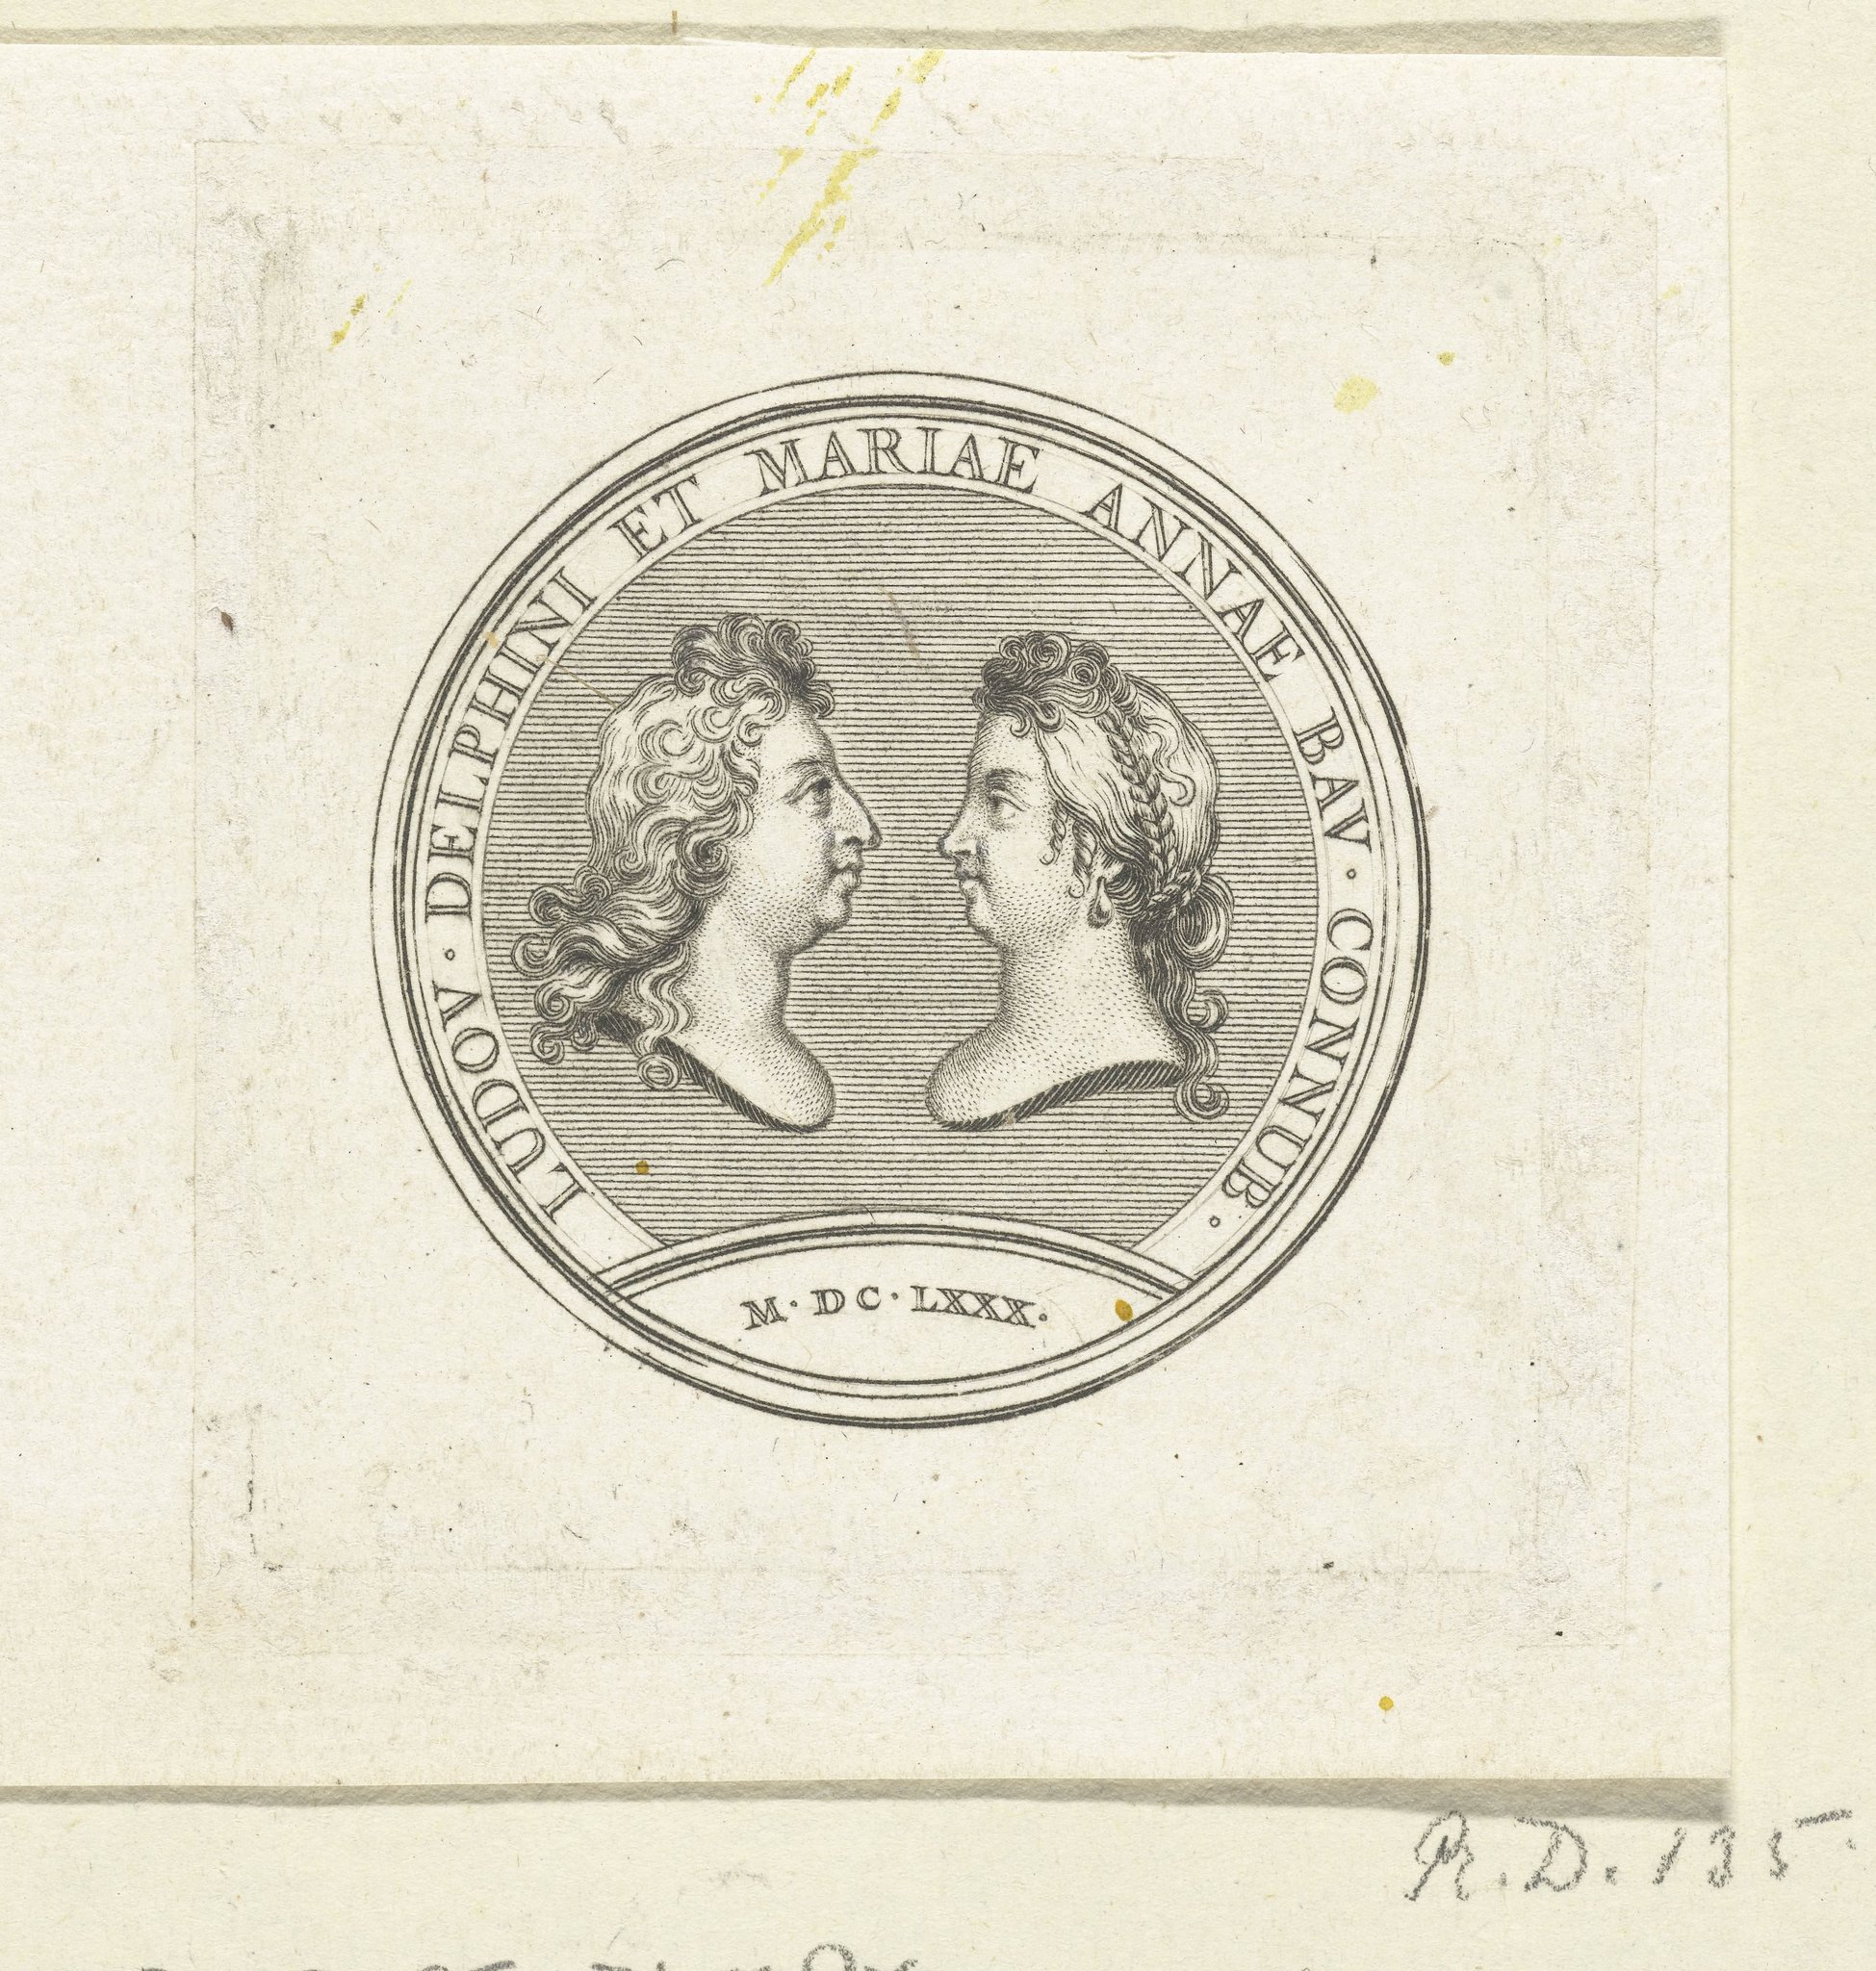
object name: print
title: Penning met bustes van Lodewijk van Frankrijk en Maria Anna van Beieren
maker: gerard edelinck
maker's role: print maker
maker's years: 1640-1707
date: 1702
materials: paper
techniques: engraving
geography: paris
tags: maria anna van beieren dauphine van frankrijk, dauphin van frankrijk lodewijk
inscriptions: collector's mark: Lugt 240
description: Achterkant van een penning met bustes en profil van Lodewijk van Frankrijk (le Grand Dauphin) en Maria Anna van Beieren, elkaar aankijkend. De penning is gedateerd 1680: het jaar van hun huwelijk.